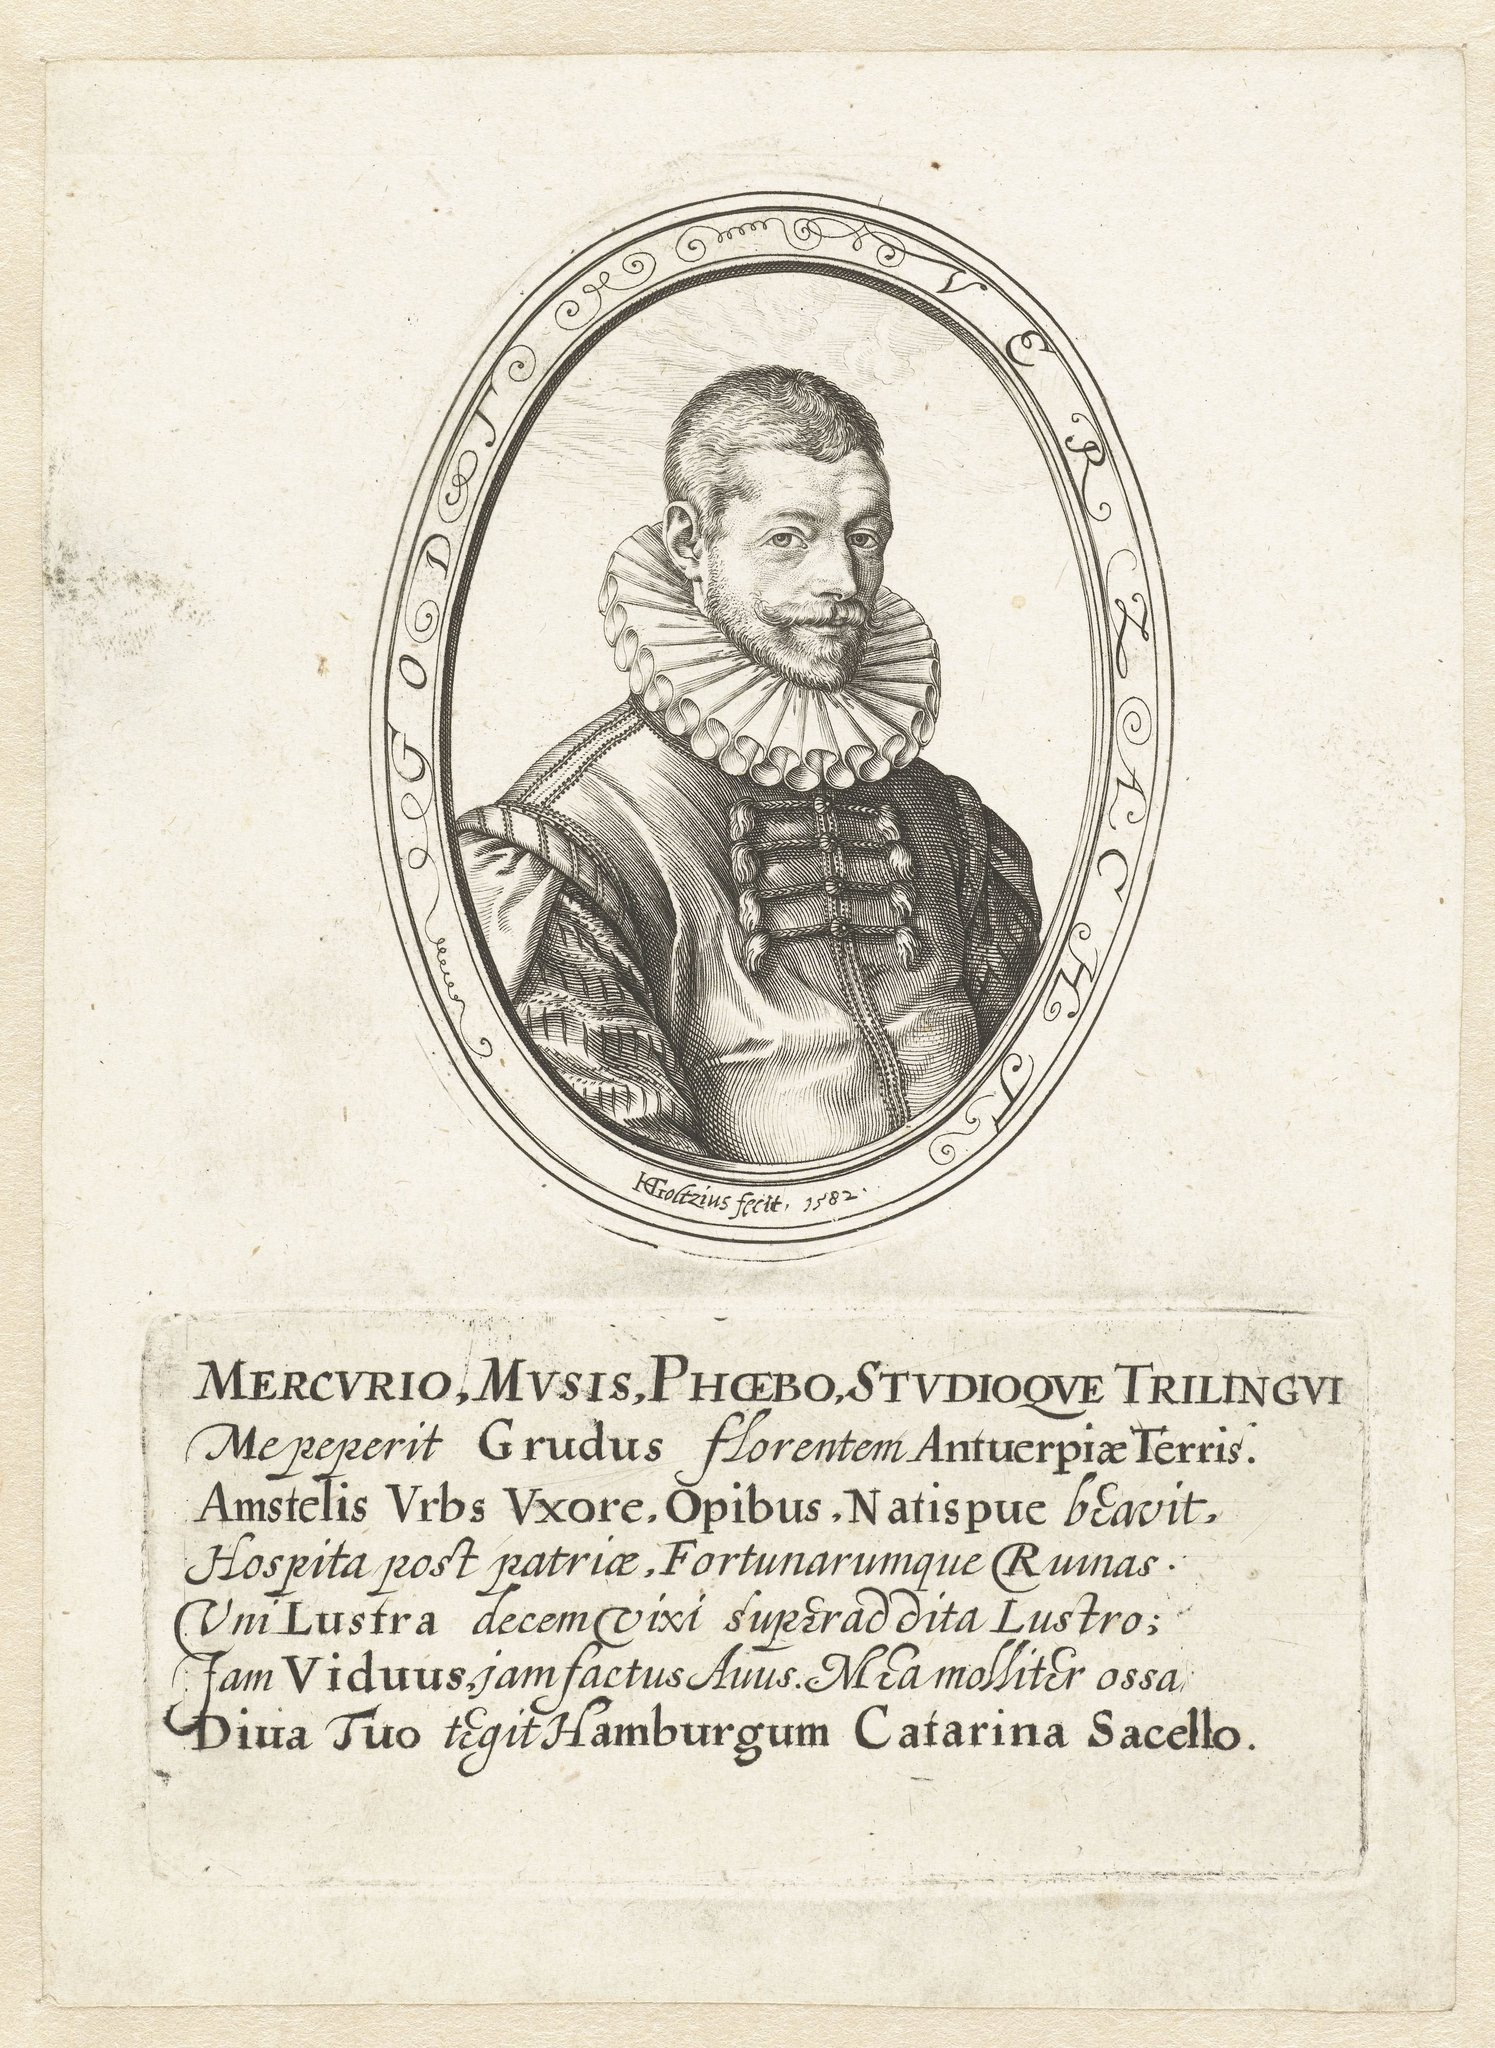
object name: print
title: Portret van Hans Felbbier of Jacob Gyscher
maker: hendrick goltzius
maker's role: draughtsman, painter, print maker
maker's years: 1558-1617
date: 1582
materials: paper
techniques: engraving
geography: haarlem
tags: neck-gear ~ clothing (with name), historical persons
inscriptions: signature and date: ‘HGoltzius fecit. 1582’, collector's mark: Lugt 240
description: Portret van een man met grote plooikraag, ten halven lijve. Niet geheel duidelijk wie hier is afgebeeld: Hans Felbbier of Jacob Gyscher. Randinscriptie rondom het ovaal. Onder het ovaal een zevenregelige Latijnse tekst, gedrukt van een aparte plaat (maar op hetzelfde blad als het portret).